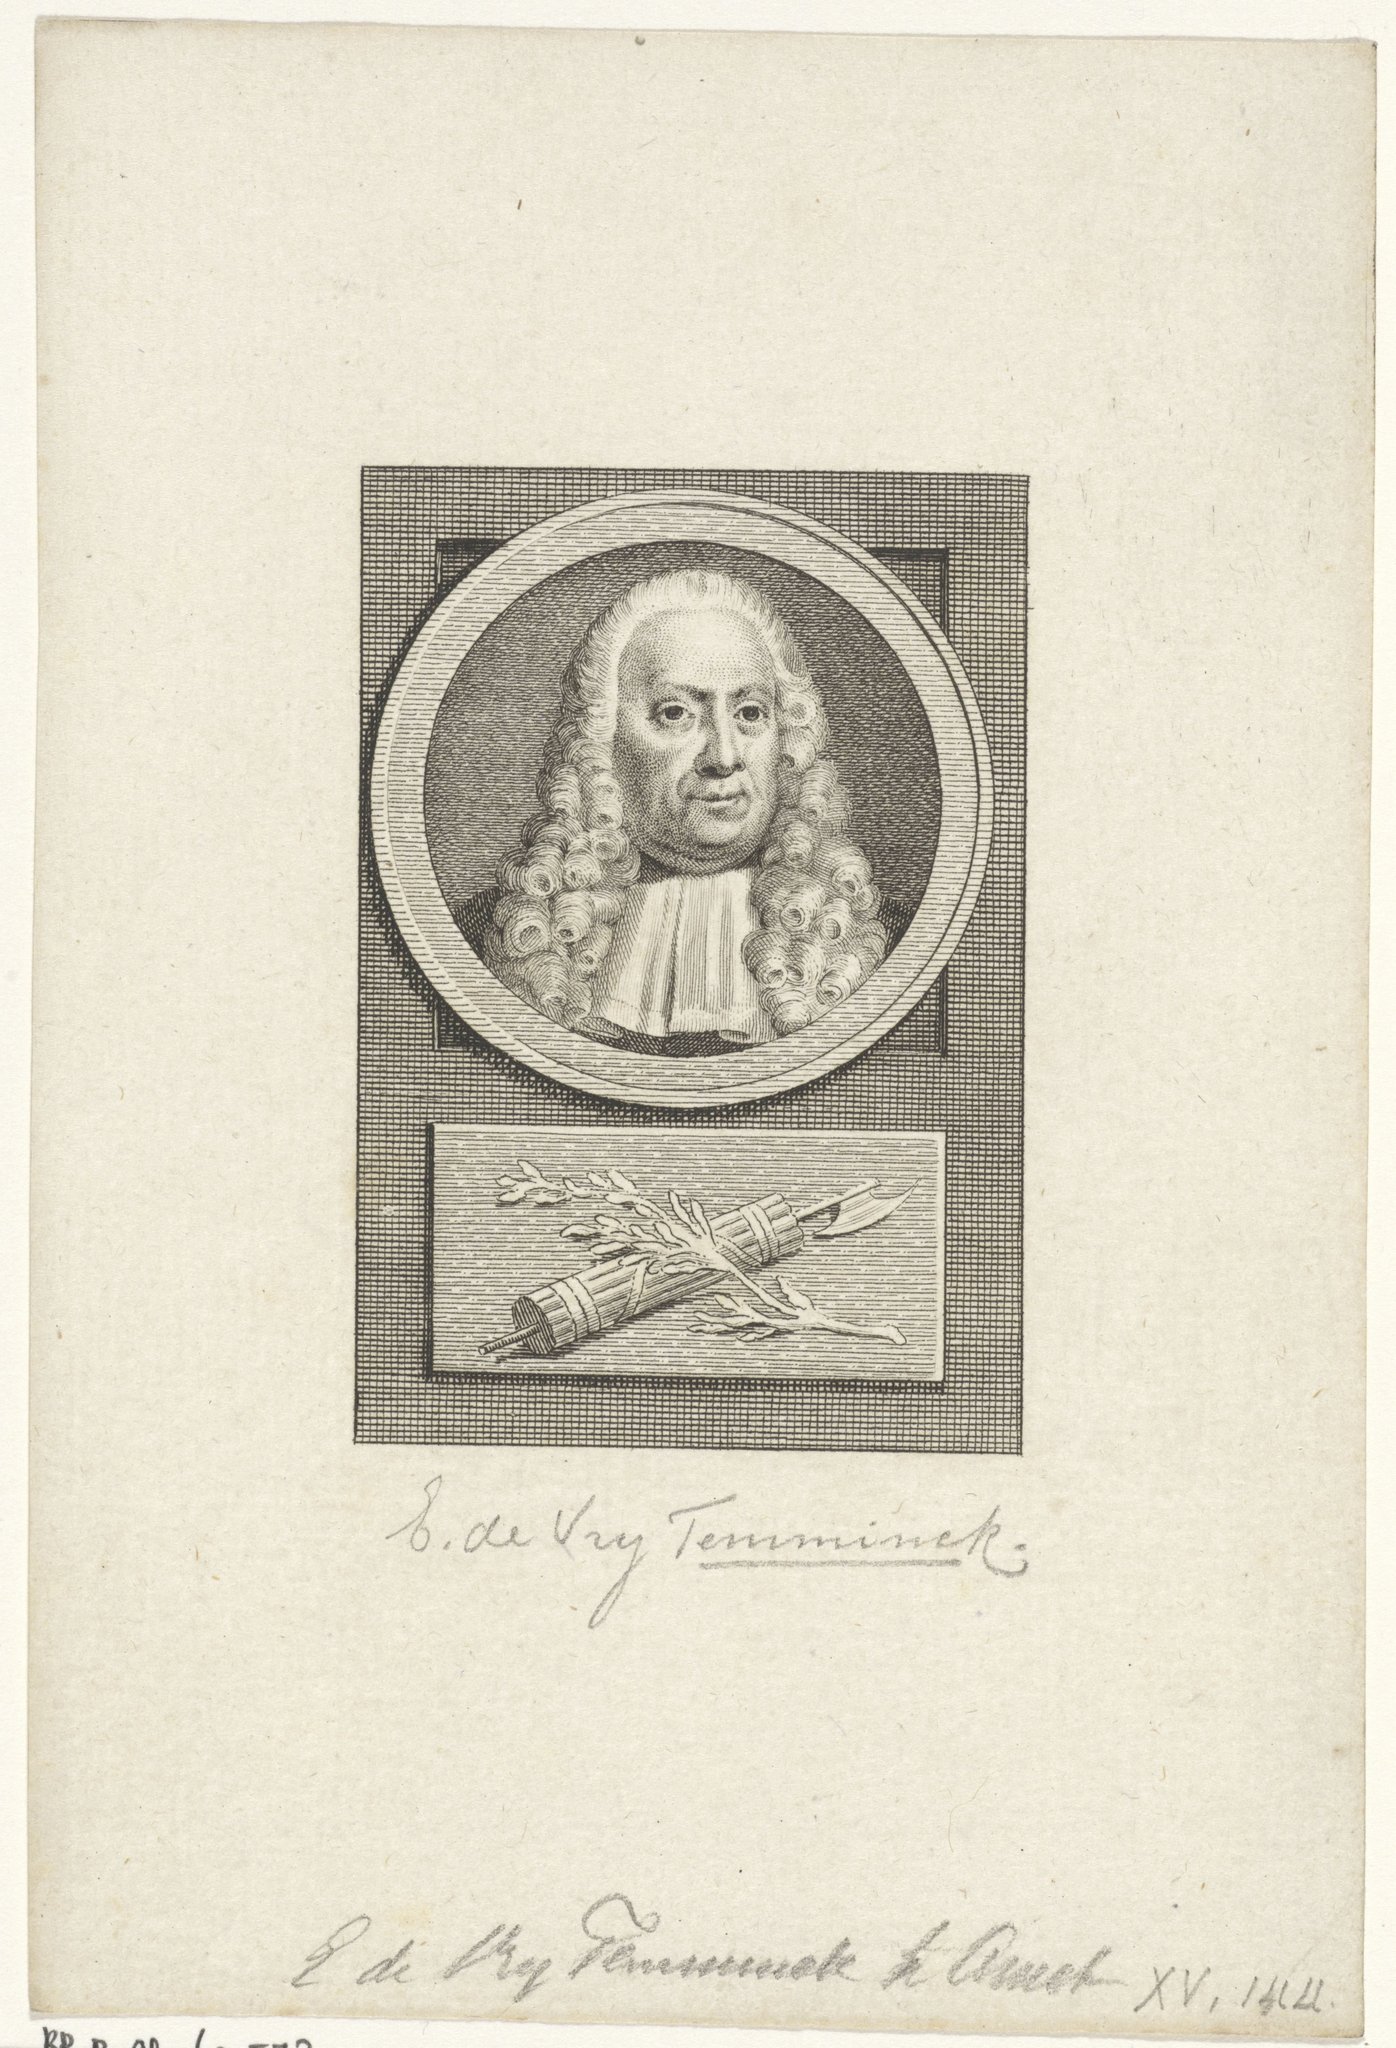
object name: print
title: Portret van Egbert de Vrij Temminck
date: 1783-1795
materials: paper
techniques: engraving, etching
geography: amsterdam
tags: amsterdam, mayor, egbert de vrij temminck, law and jurisprudence (+ 'fasces cum securibus')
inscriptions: collector's mark: Lugt 2228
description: Latere staat prent gebruikt in: Fokke, Jan. Geschiedenissen der Vereenigde Nederlanden voor de vaderlandsche jeugd Ie-XXVste deel. Amsterdam: Johannes Allart, 1783-1795. Deel XV.